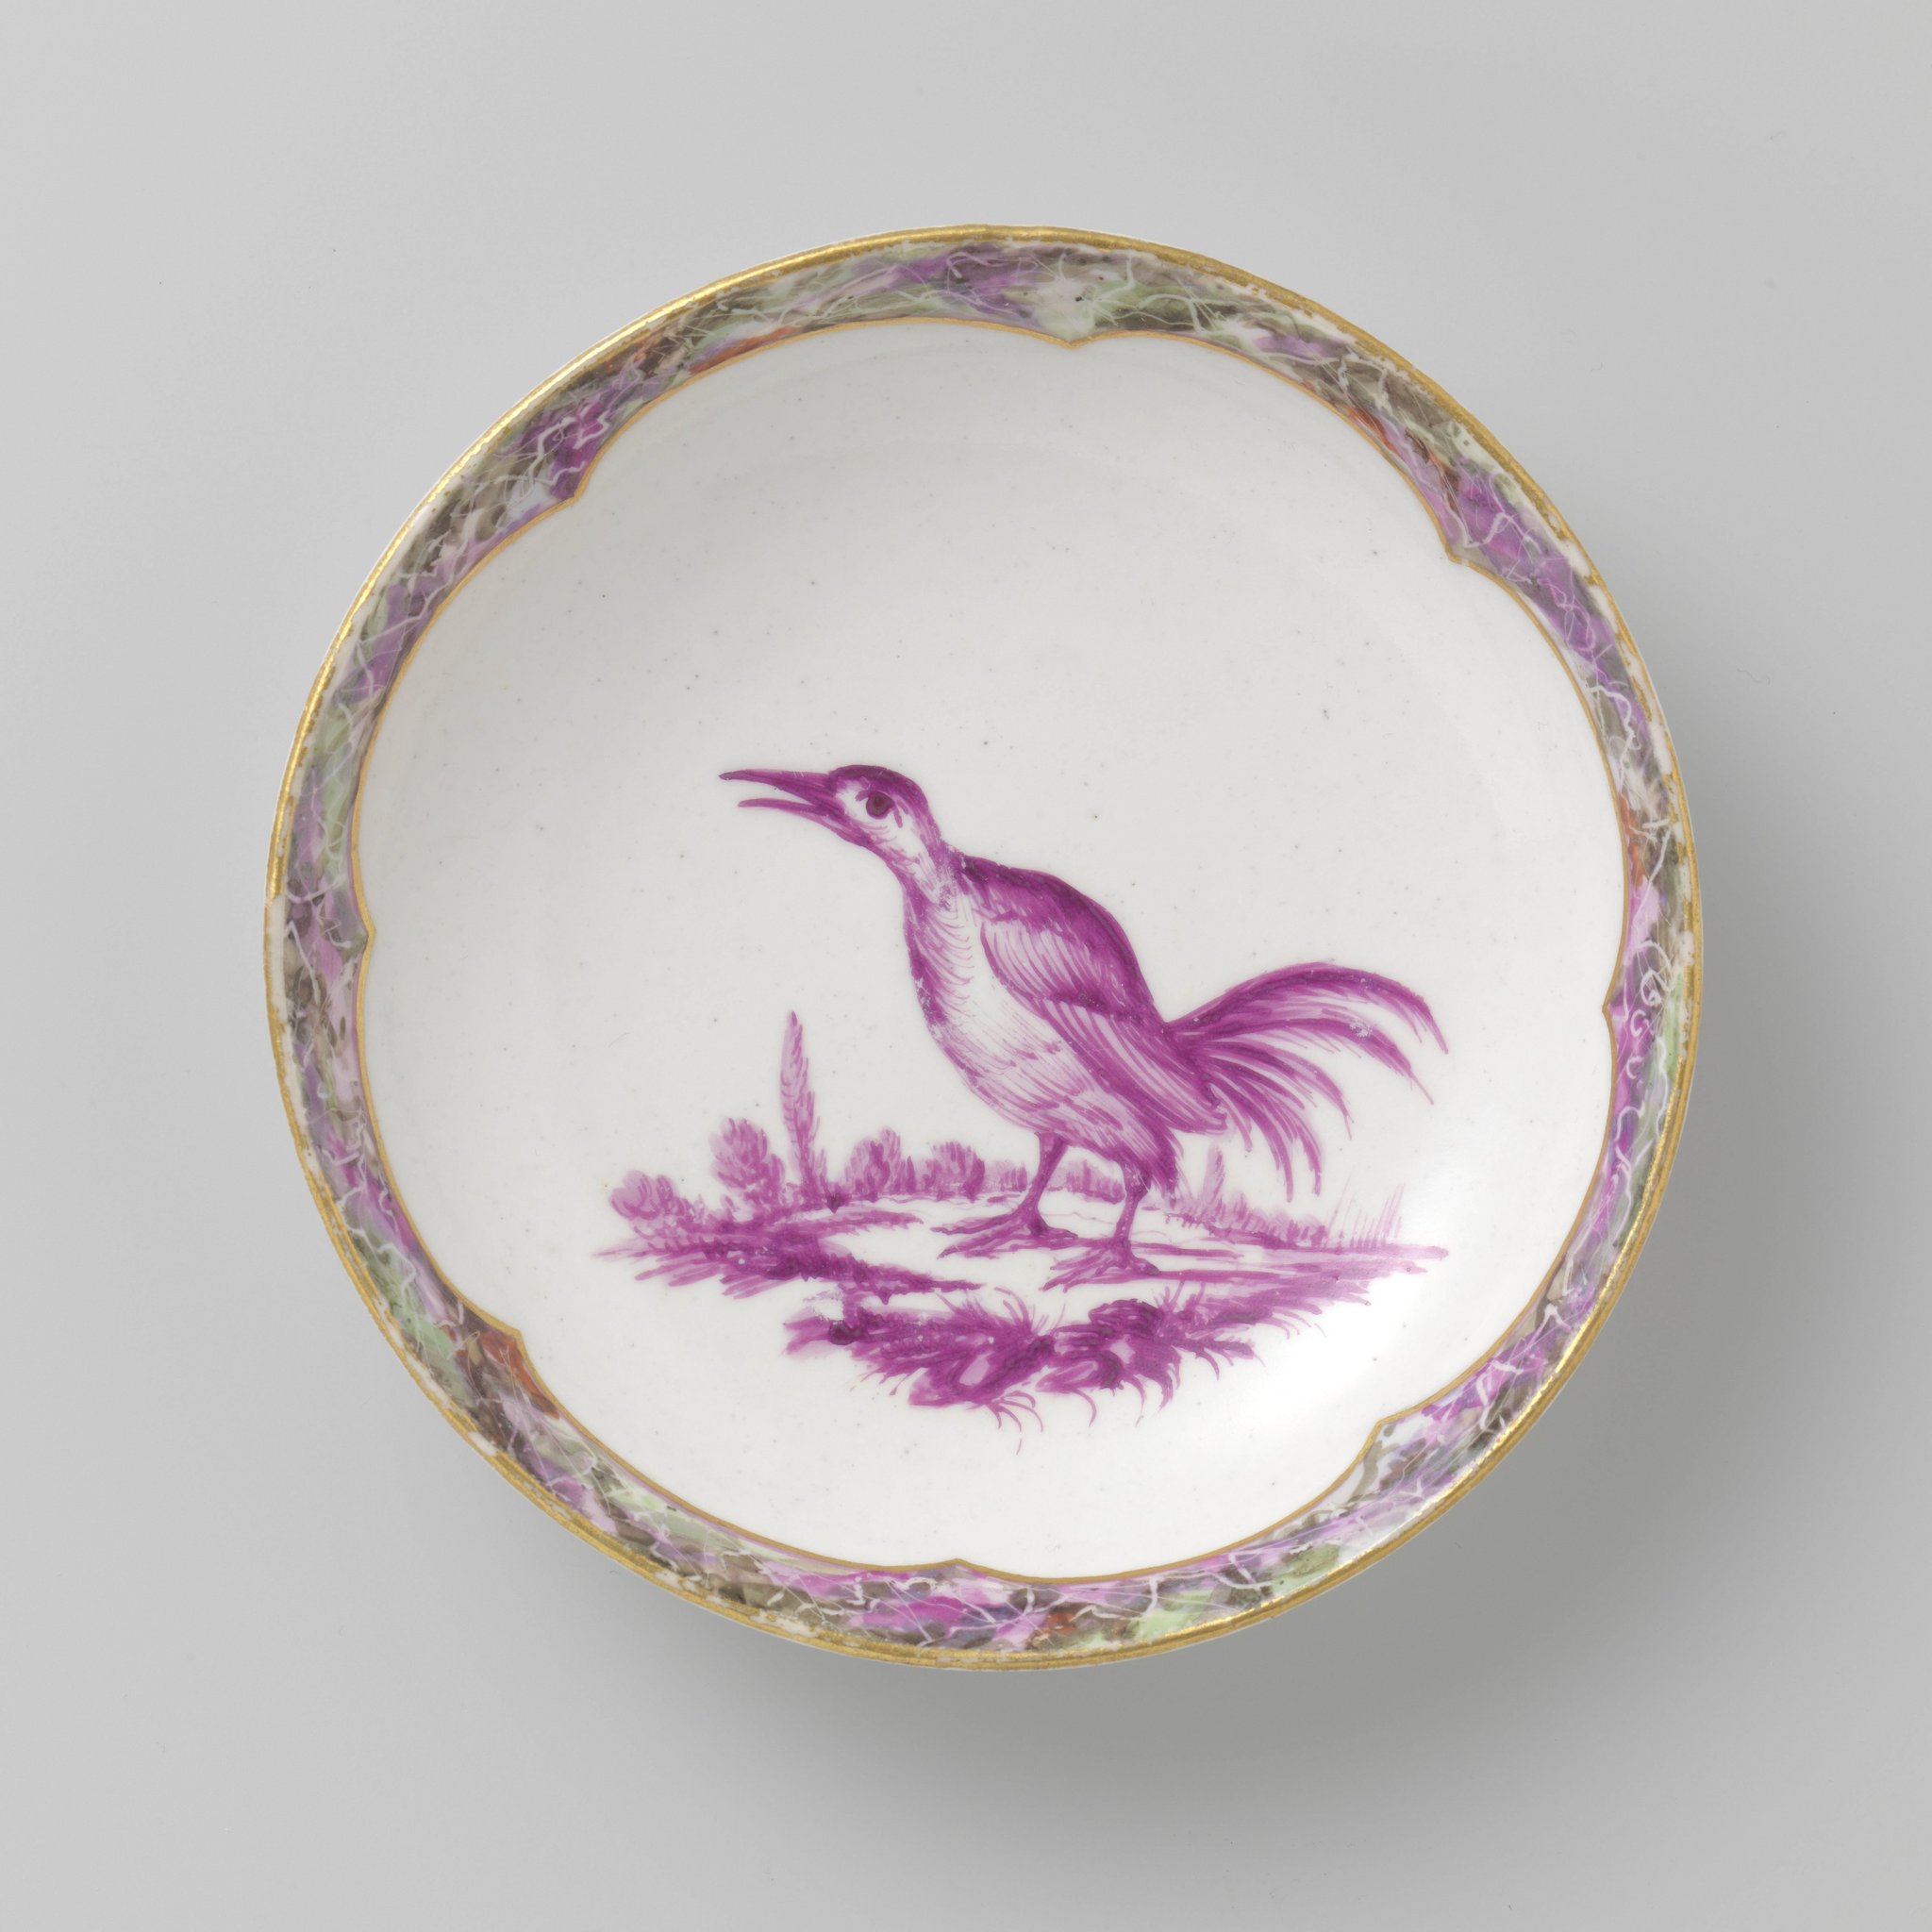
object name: platter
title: Cup and saucer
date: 1778-1782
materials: porcelain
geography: loosdrecht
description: Manufactuur Oud-Loosdrecht Loosdrecht, c. 1778–1782 hard-paste porcelain